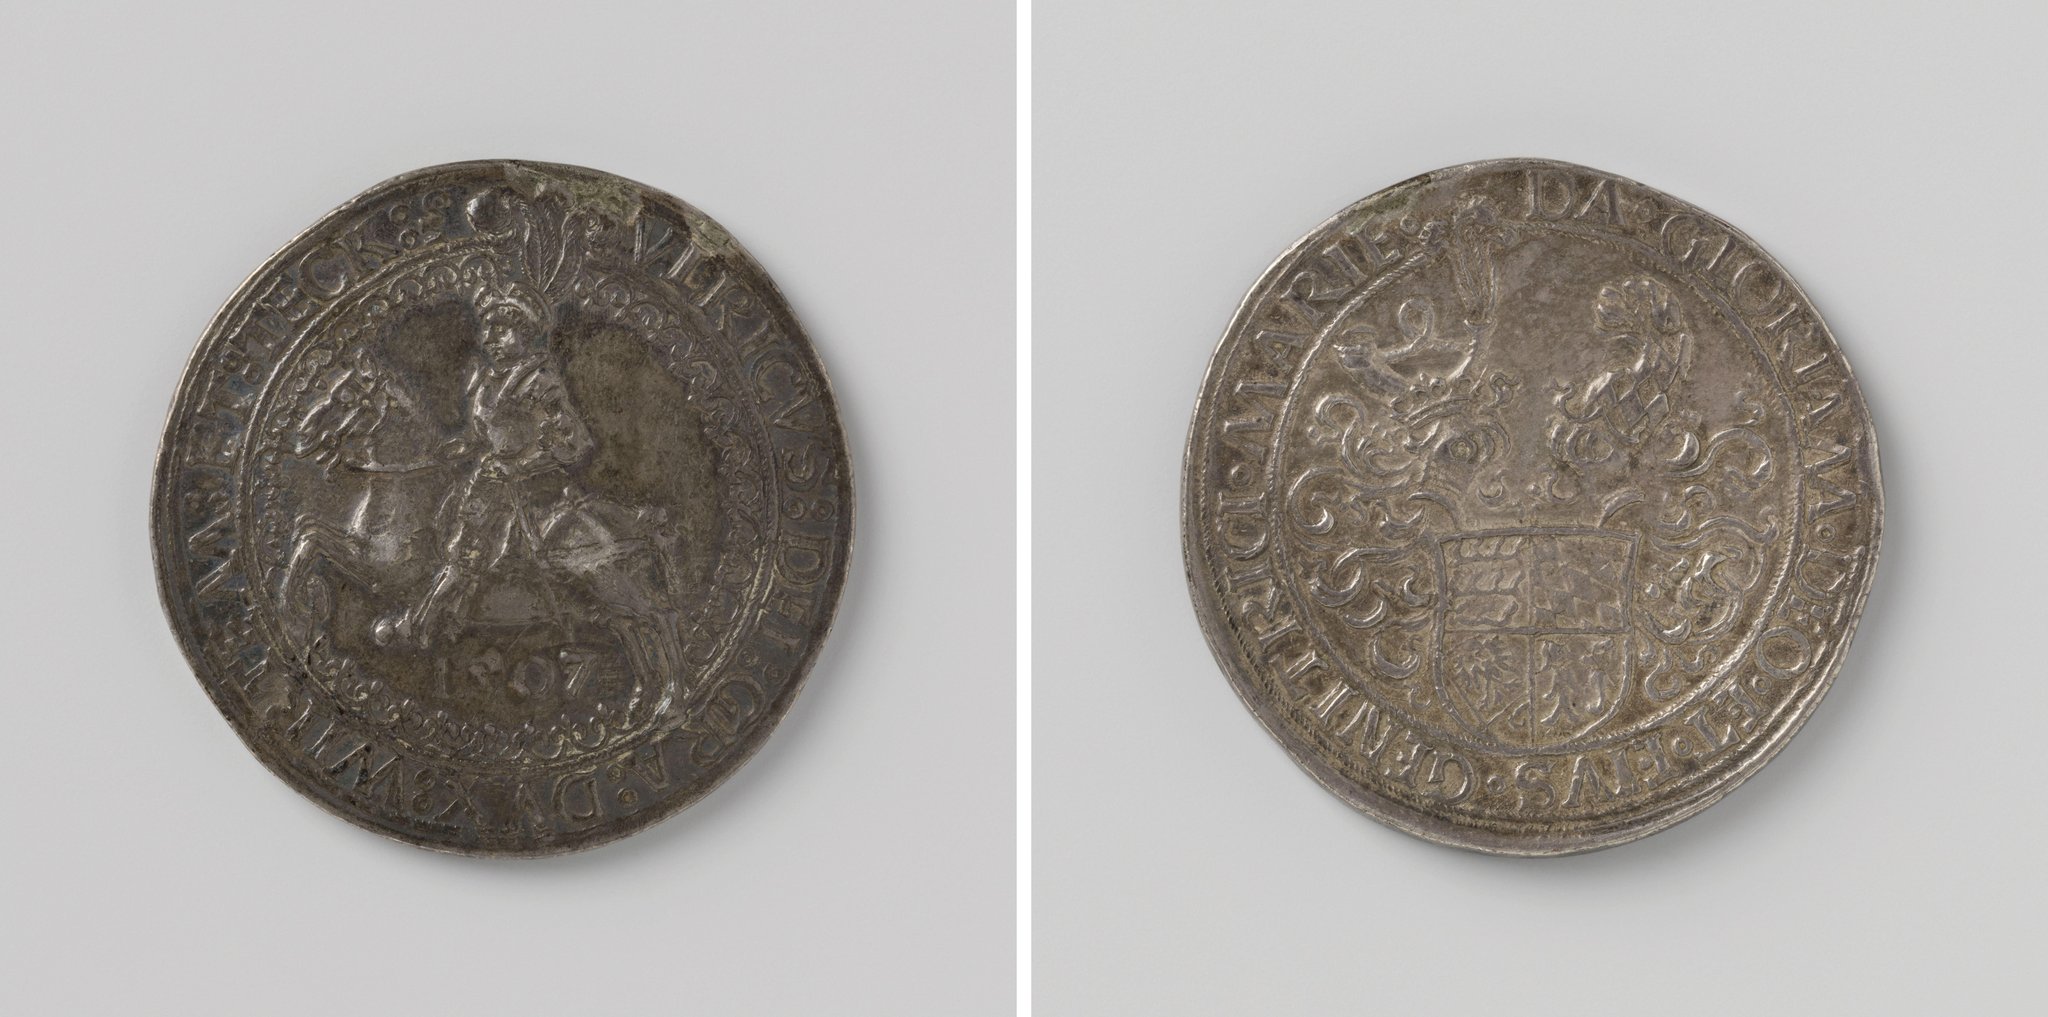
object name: coin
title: Taler uit Württemburg-Teck op naam van hertog Ulrich (1498-1550)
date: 1507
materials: silver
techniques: striking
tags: albrecht scholderer, kaspar scholl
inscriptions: circumscription: ‘VLRICVS : DEI : GRA : DVX : WIRTEM : ET : TECK : (lees : als twee cirkels onder elkaar)’, circumscription: ‘DA o GLORIAM o DEO o ET o EIVS o GENITRICI o MARIE o’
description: Zilveren munt. Voorzijde: ruiter boven jaartal, binnen sierrand en omschrift. Keerzijde: wapenschild gekroond met twee helmen binnen omschrift